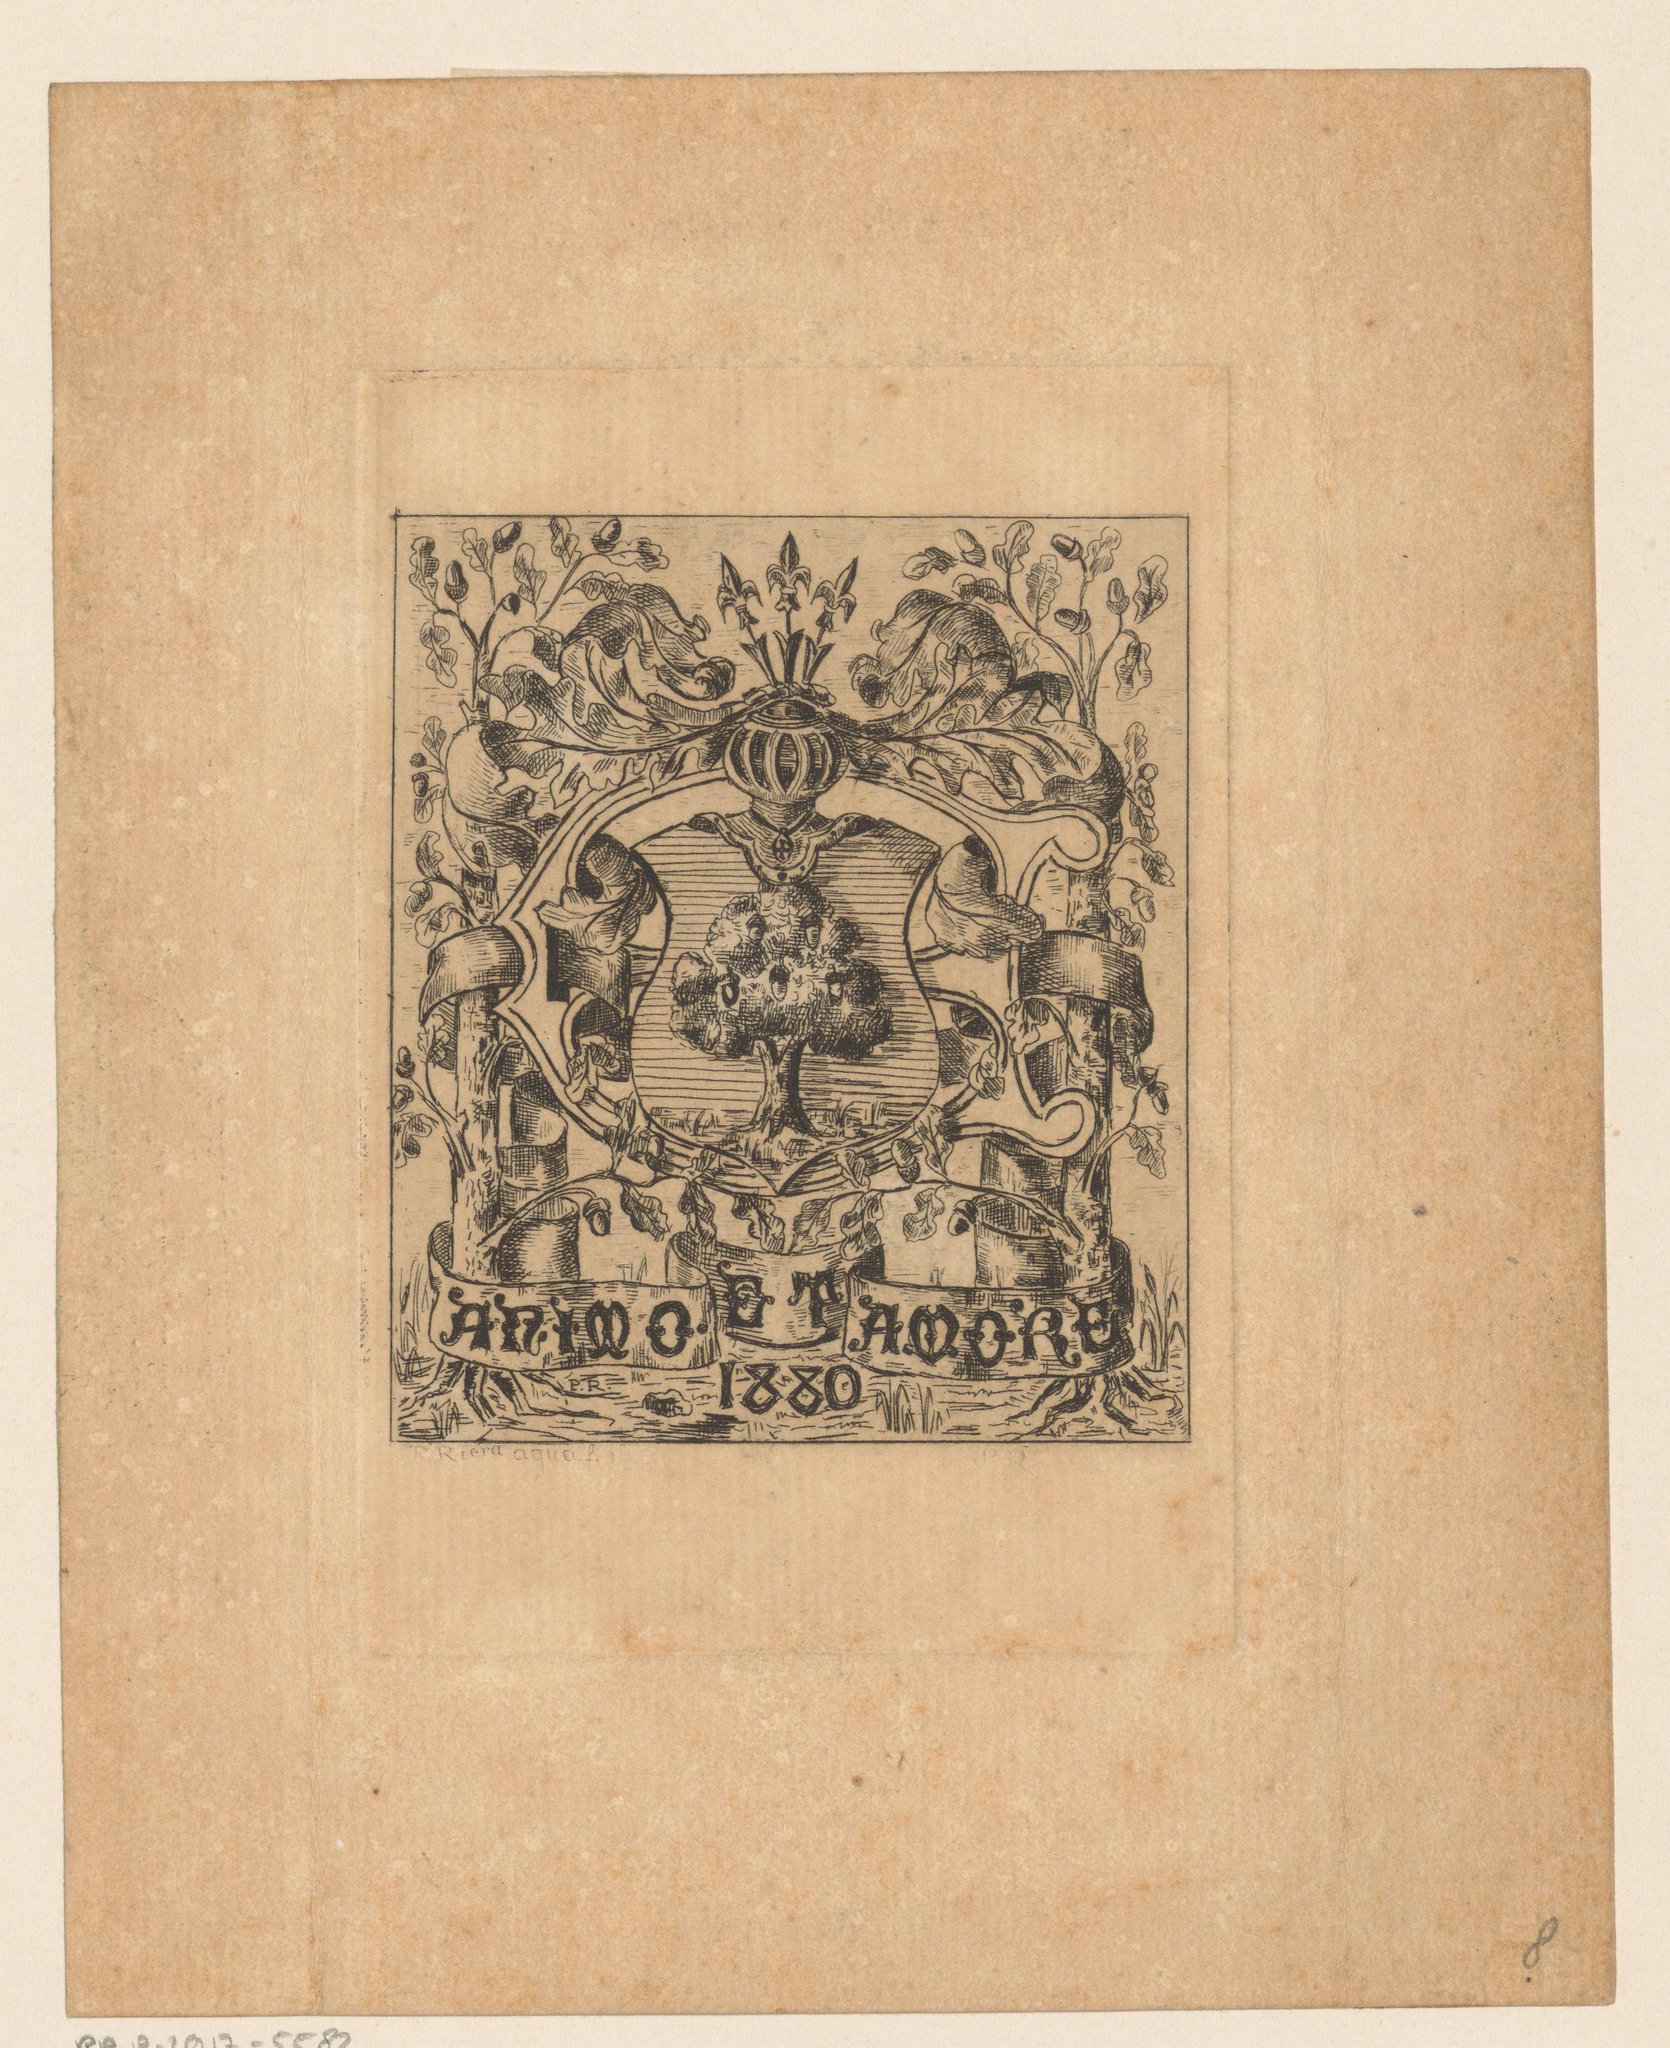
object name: bookplate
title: Animo et amore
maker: p. riera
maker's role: print maker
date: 1880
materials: paper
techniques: etching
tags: trees: oak, armorial bearing, heraldry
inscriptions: date